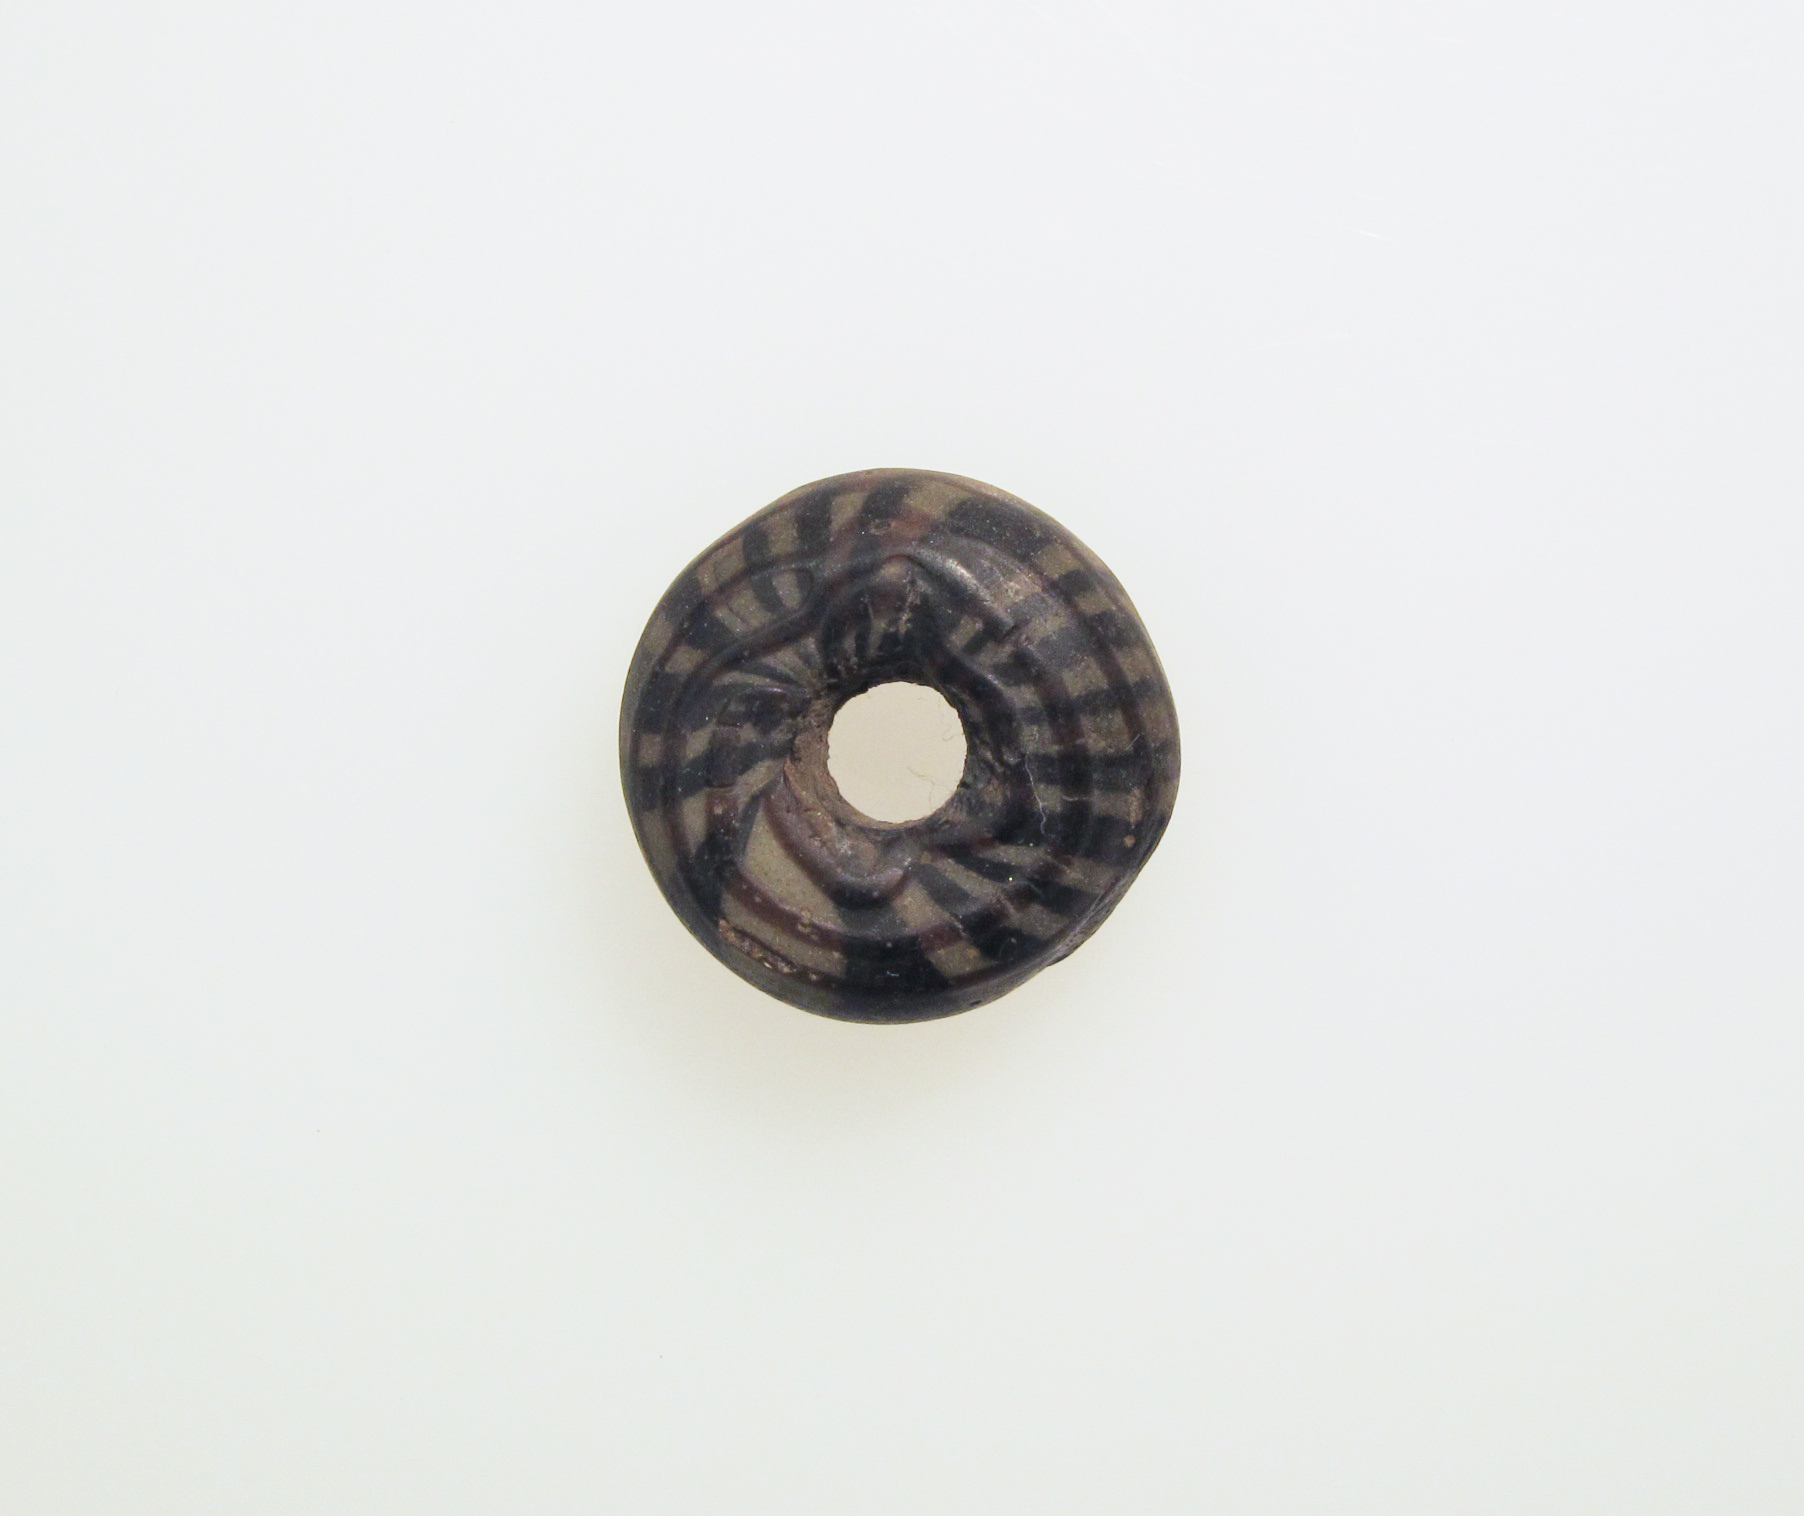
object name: bead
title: Glass bead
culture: roman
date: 670 BCE-330 CE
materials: glass